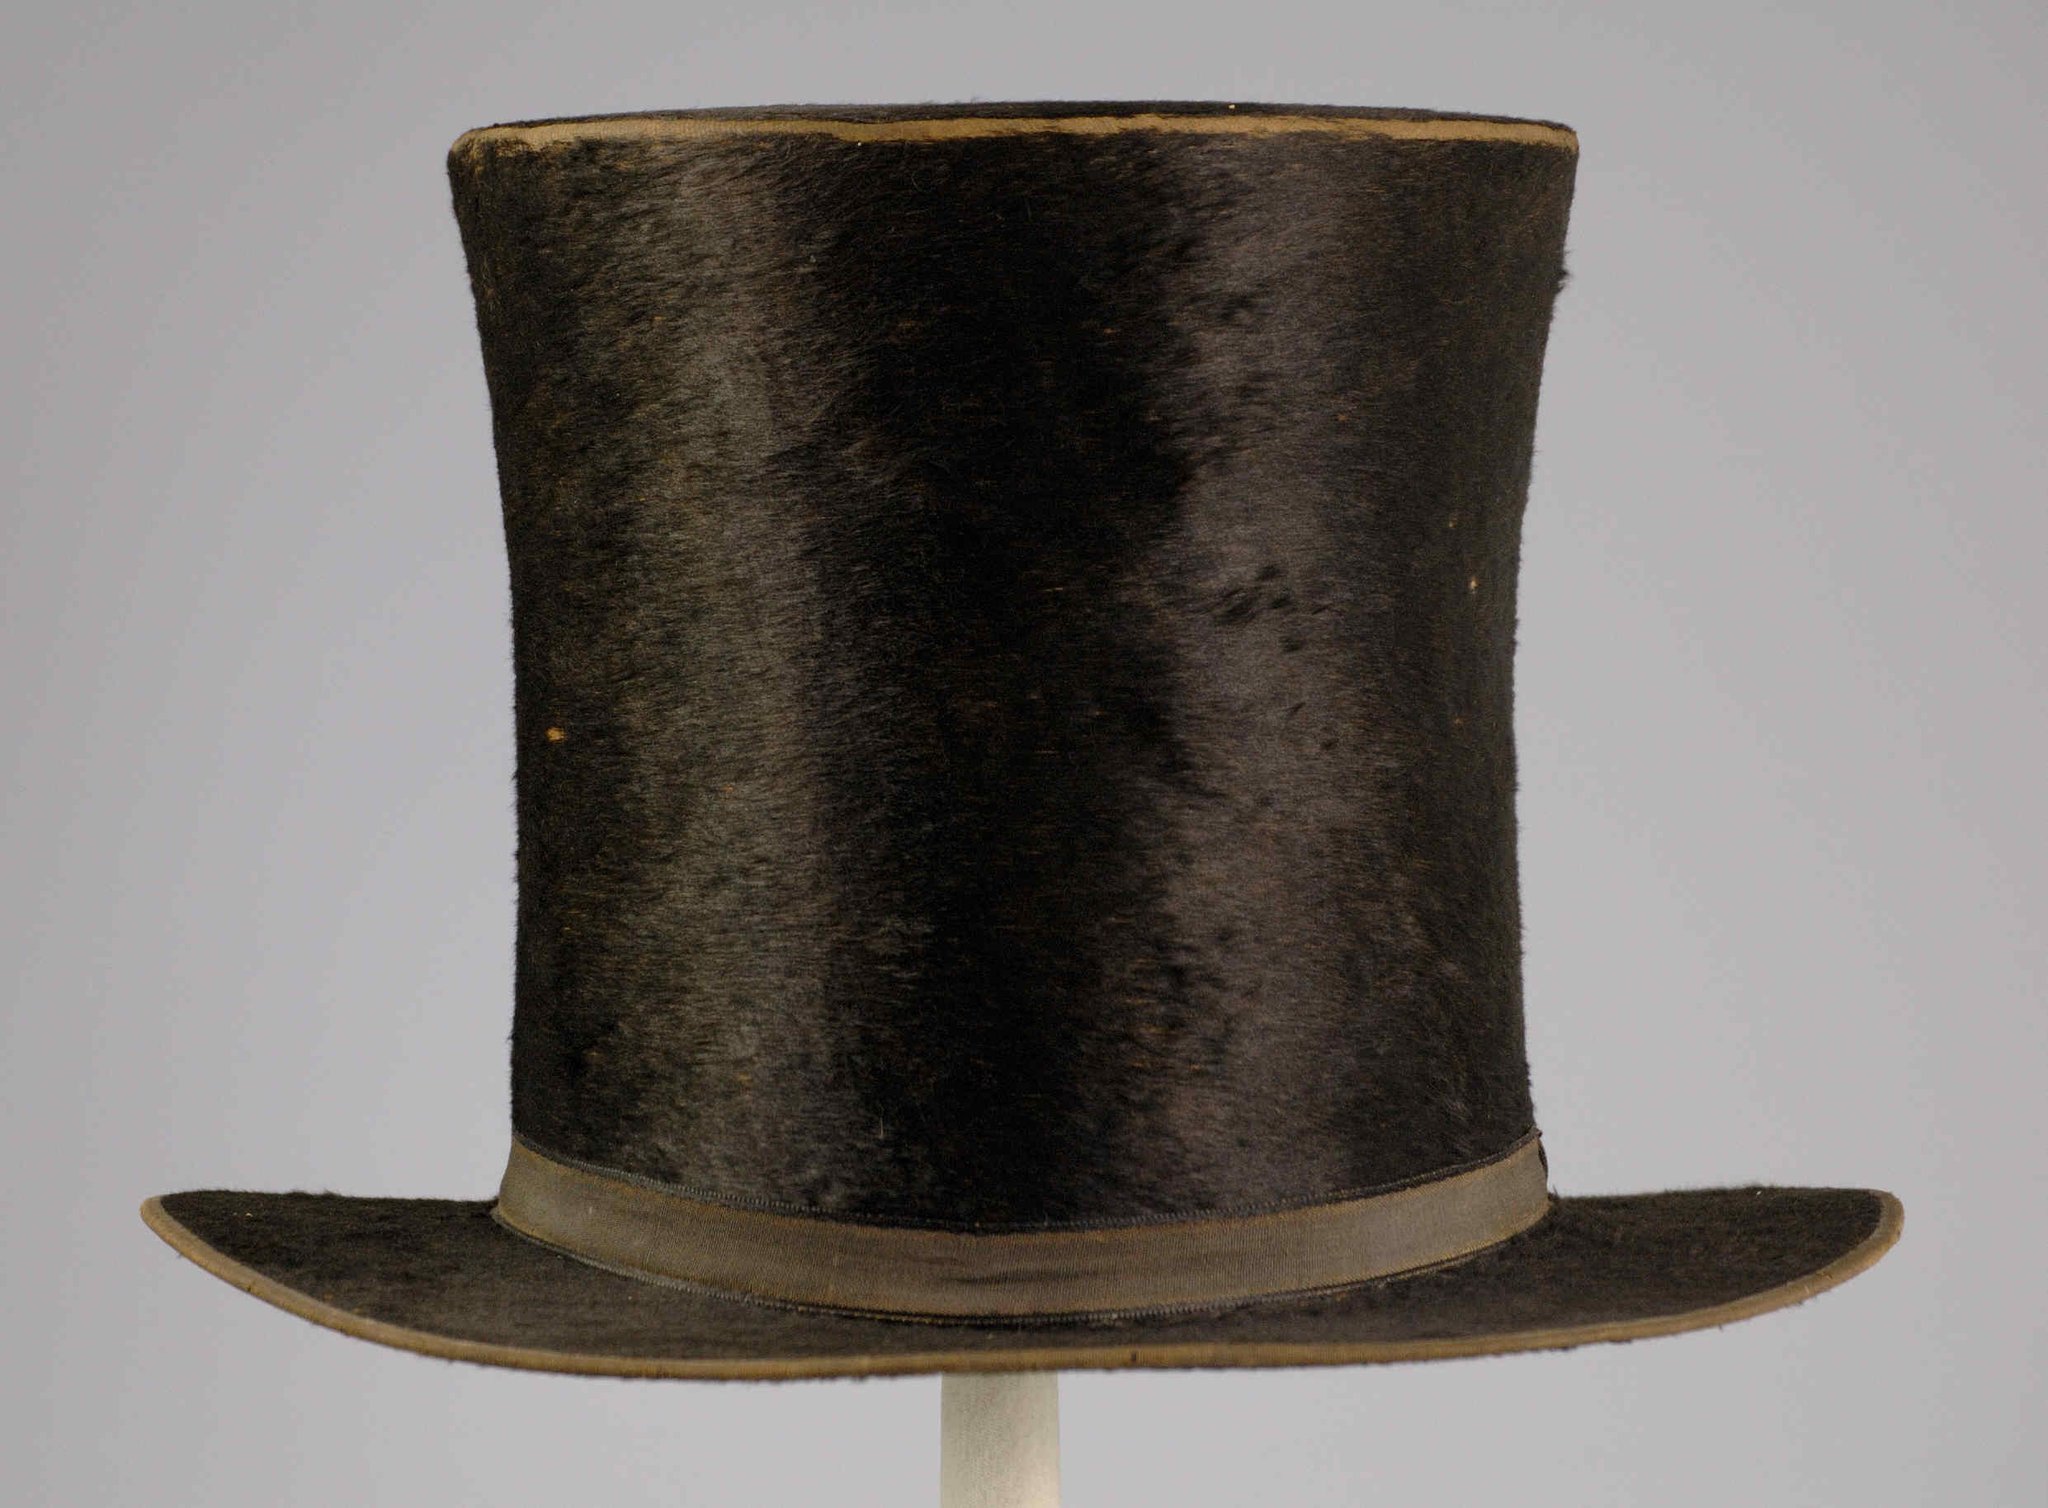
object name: top hat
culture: american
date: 1845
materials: fur, silk